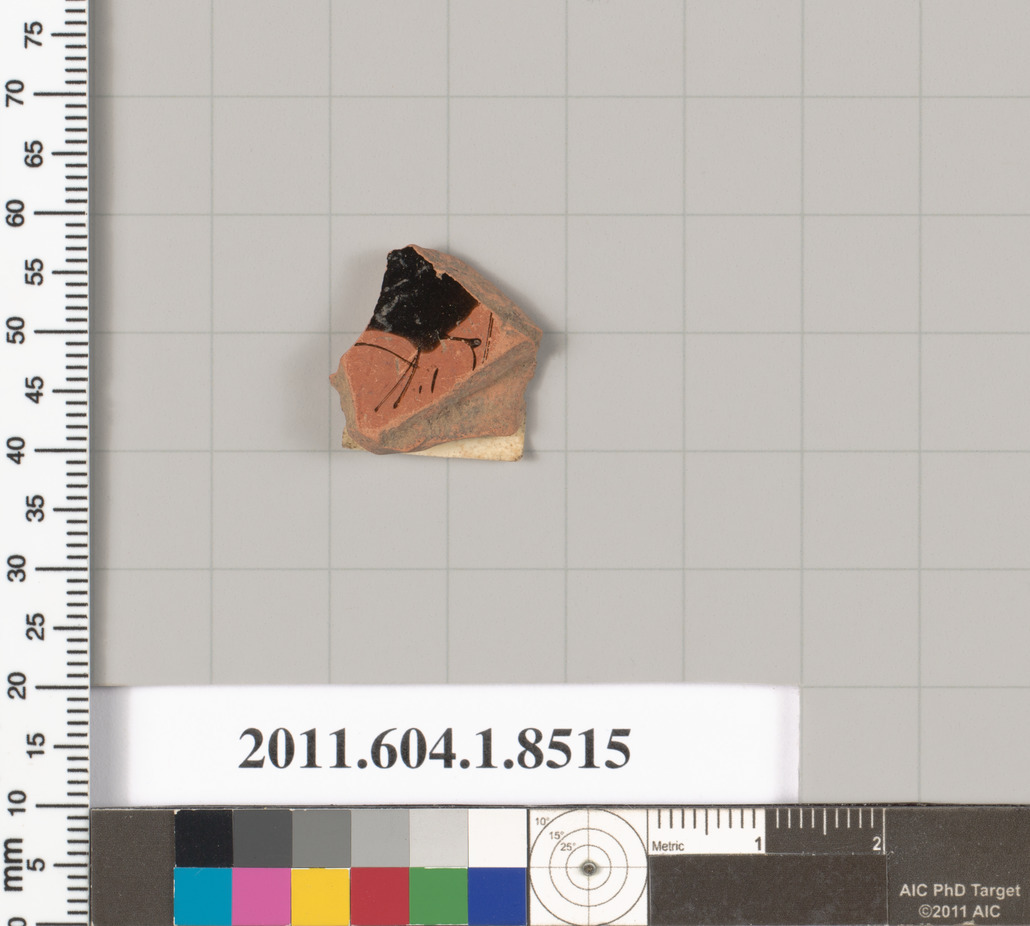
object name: kylix fragment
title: Terracotta fragment of a stemless kylix (drinking cup)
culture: greek, attic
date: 467-435 BCE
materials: terracotta